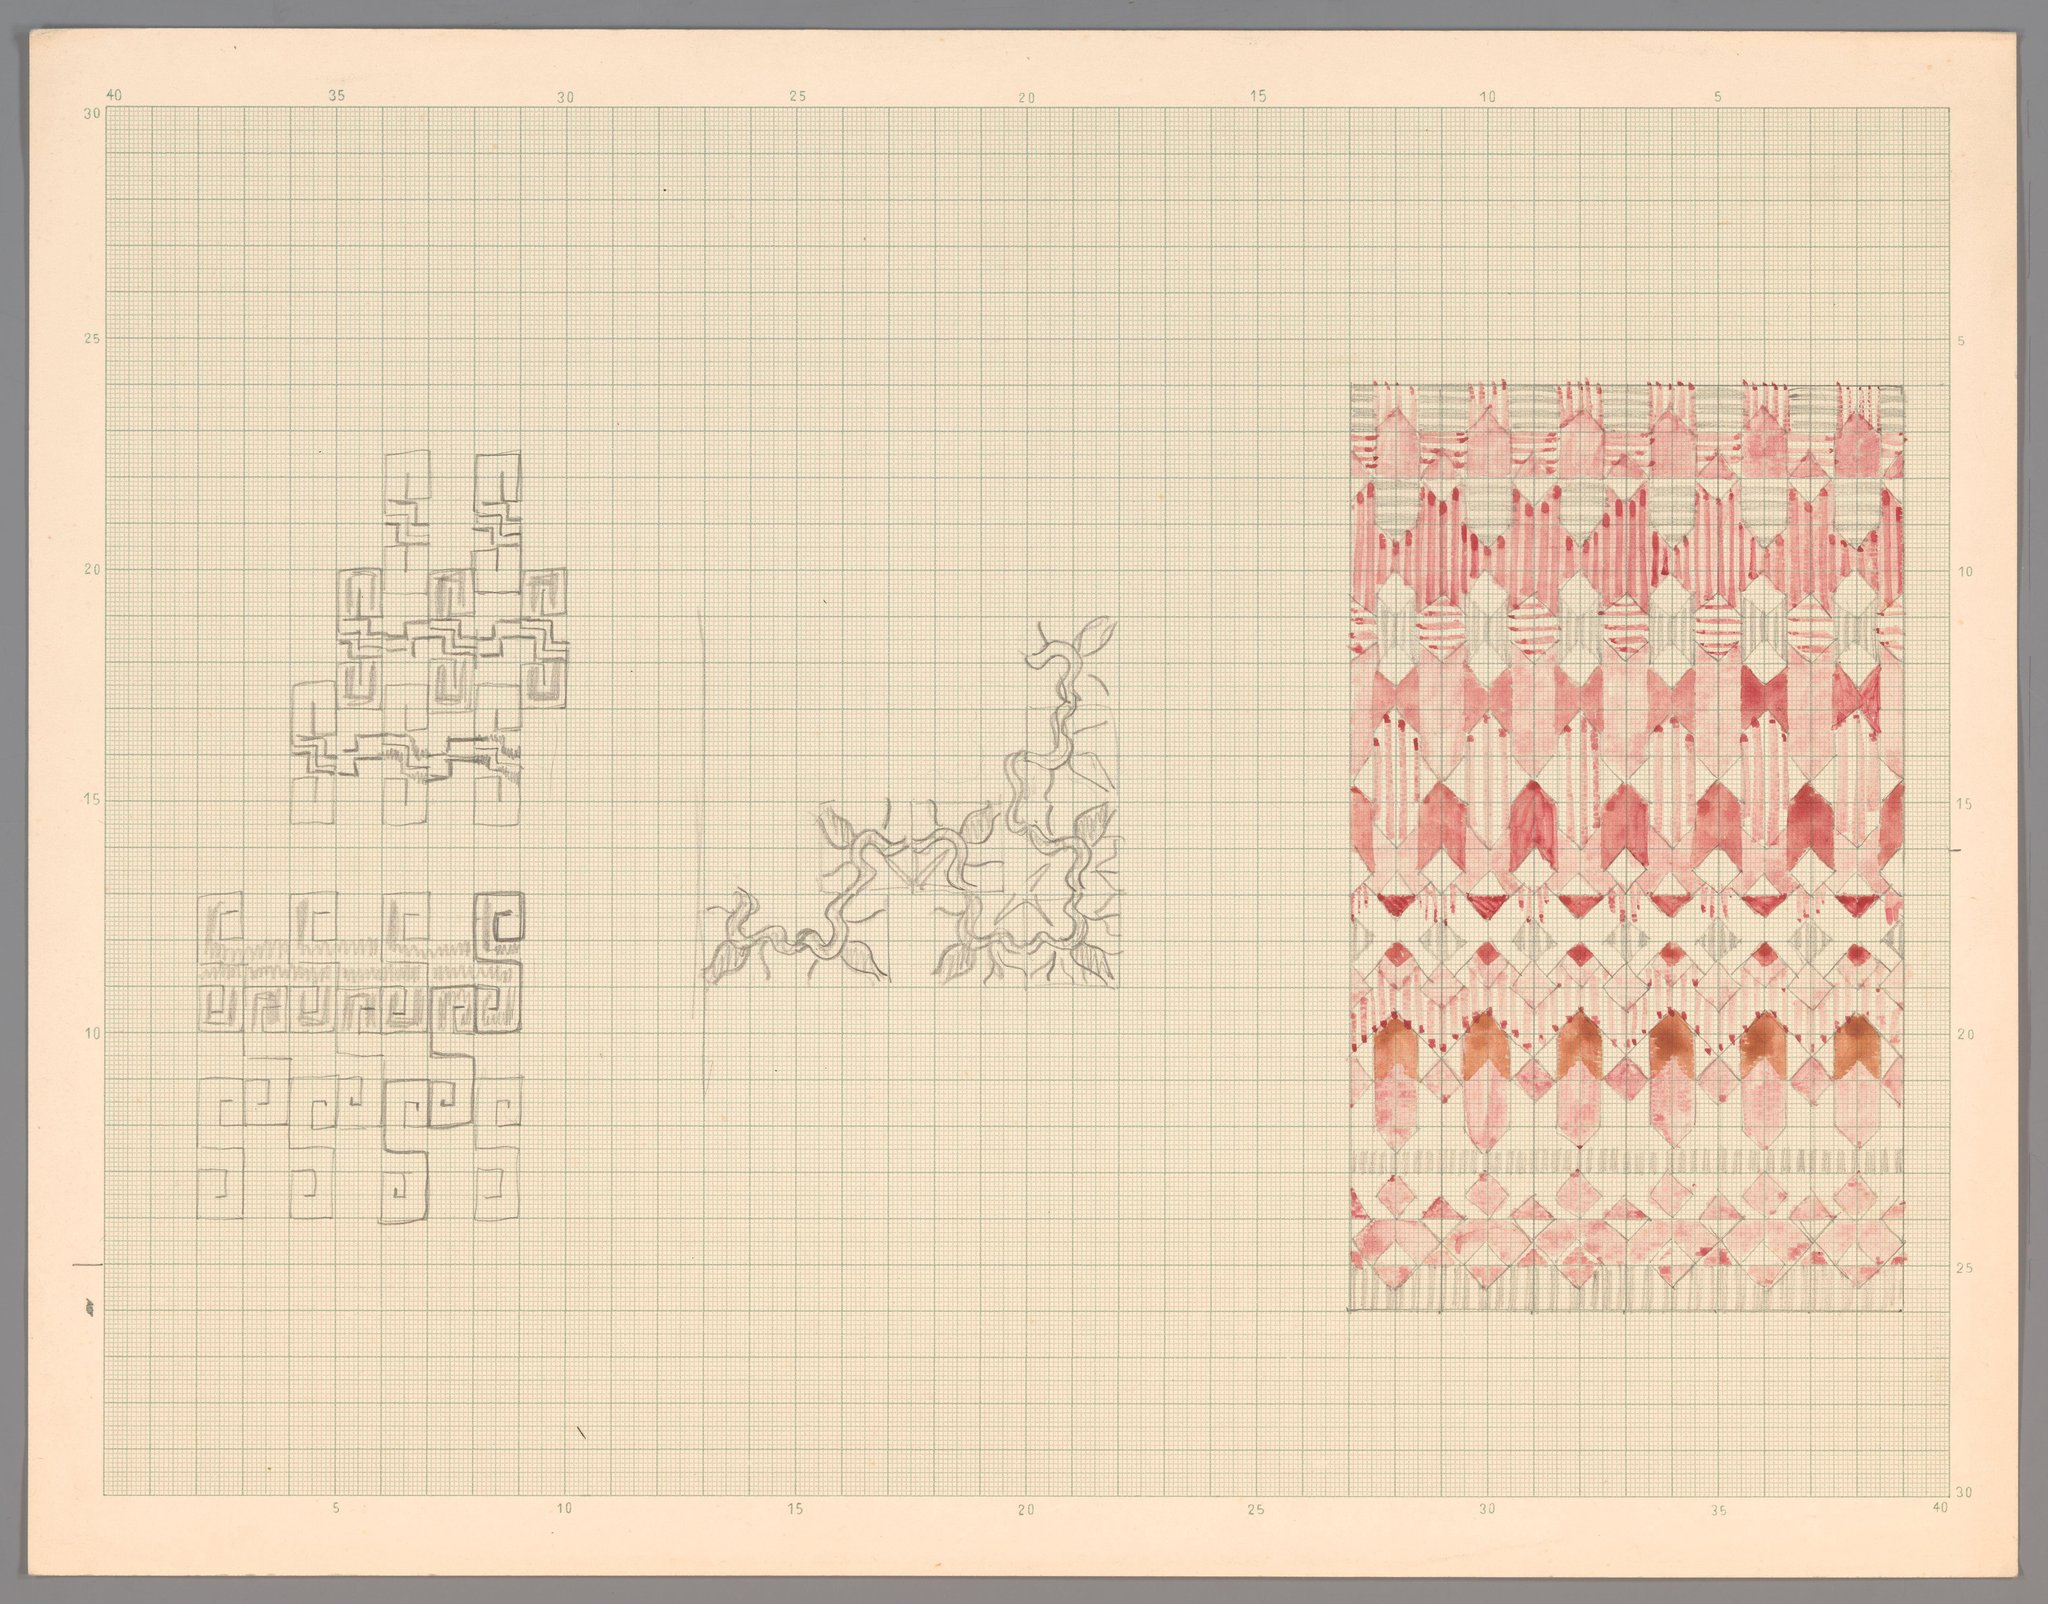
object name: drawing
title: Enkele ontwerpen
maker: carel adolph lion cachet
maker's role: draughtsman, print maker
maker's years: 1864-1945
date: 1874-1945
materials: pencil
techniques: brush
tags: ornaments ~ art